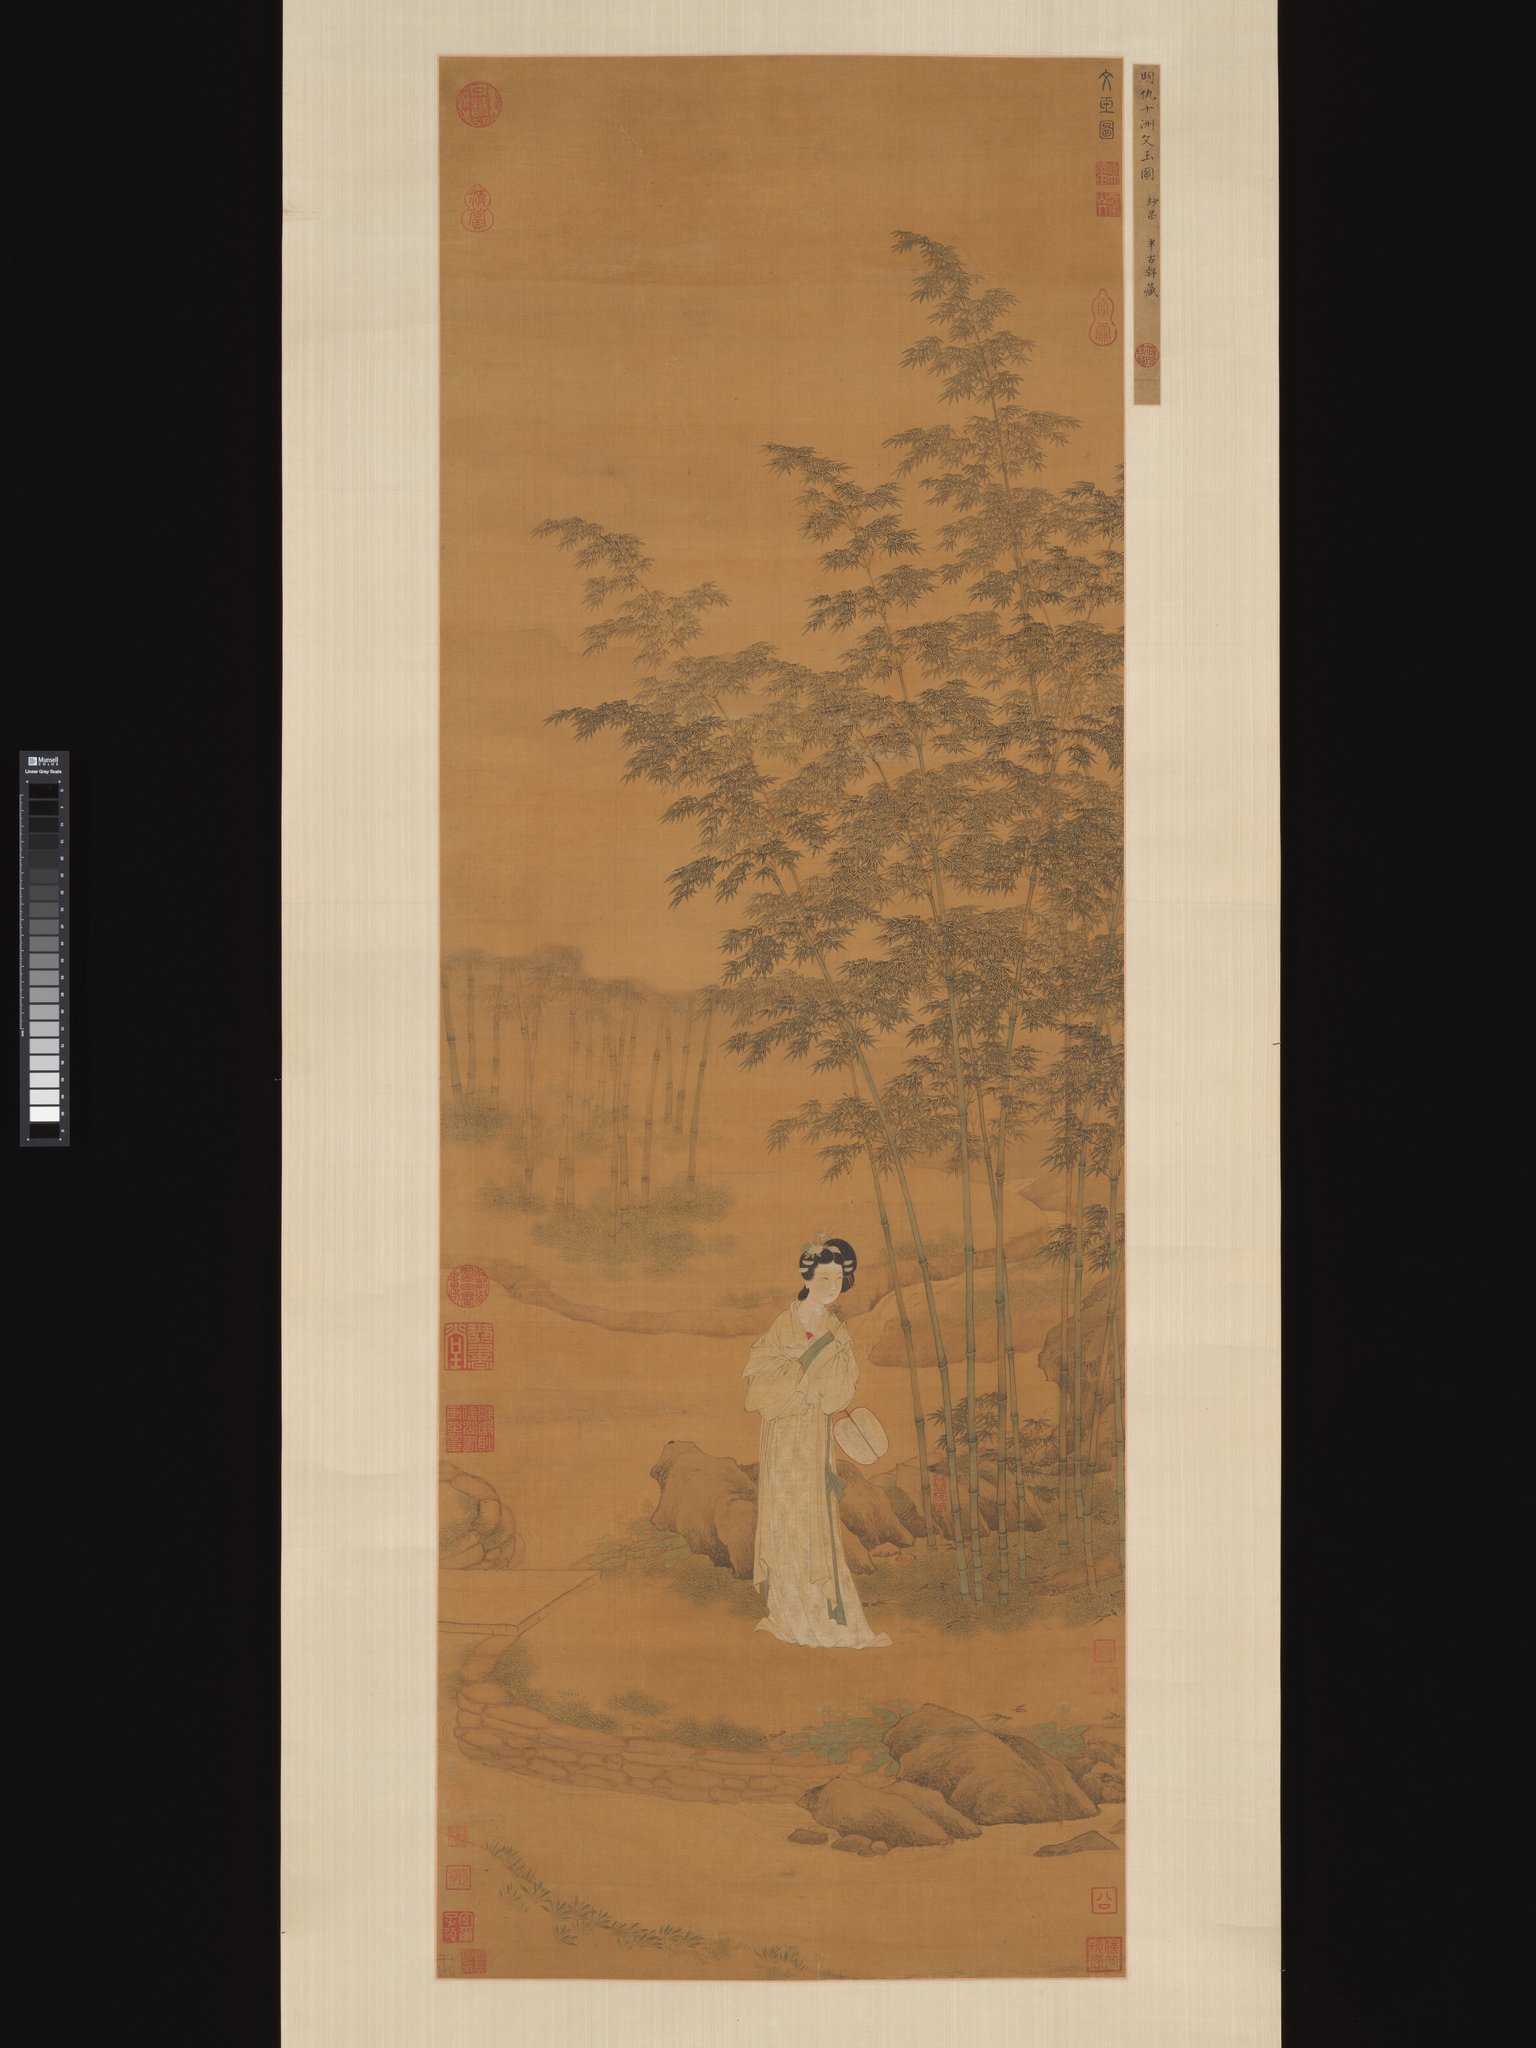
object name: hanging scroll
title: Lady in a bamboo grove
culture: chinese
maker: qiu ying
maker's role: artist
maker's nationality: chinese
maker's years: 1485-1562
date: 1495-1552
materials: ink, silk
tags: women,bamboo